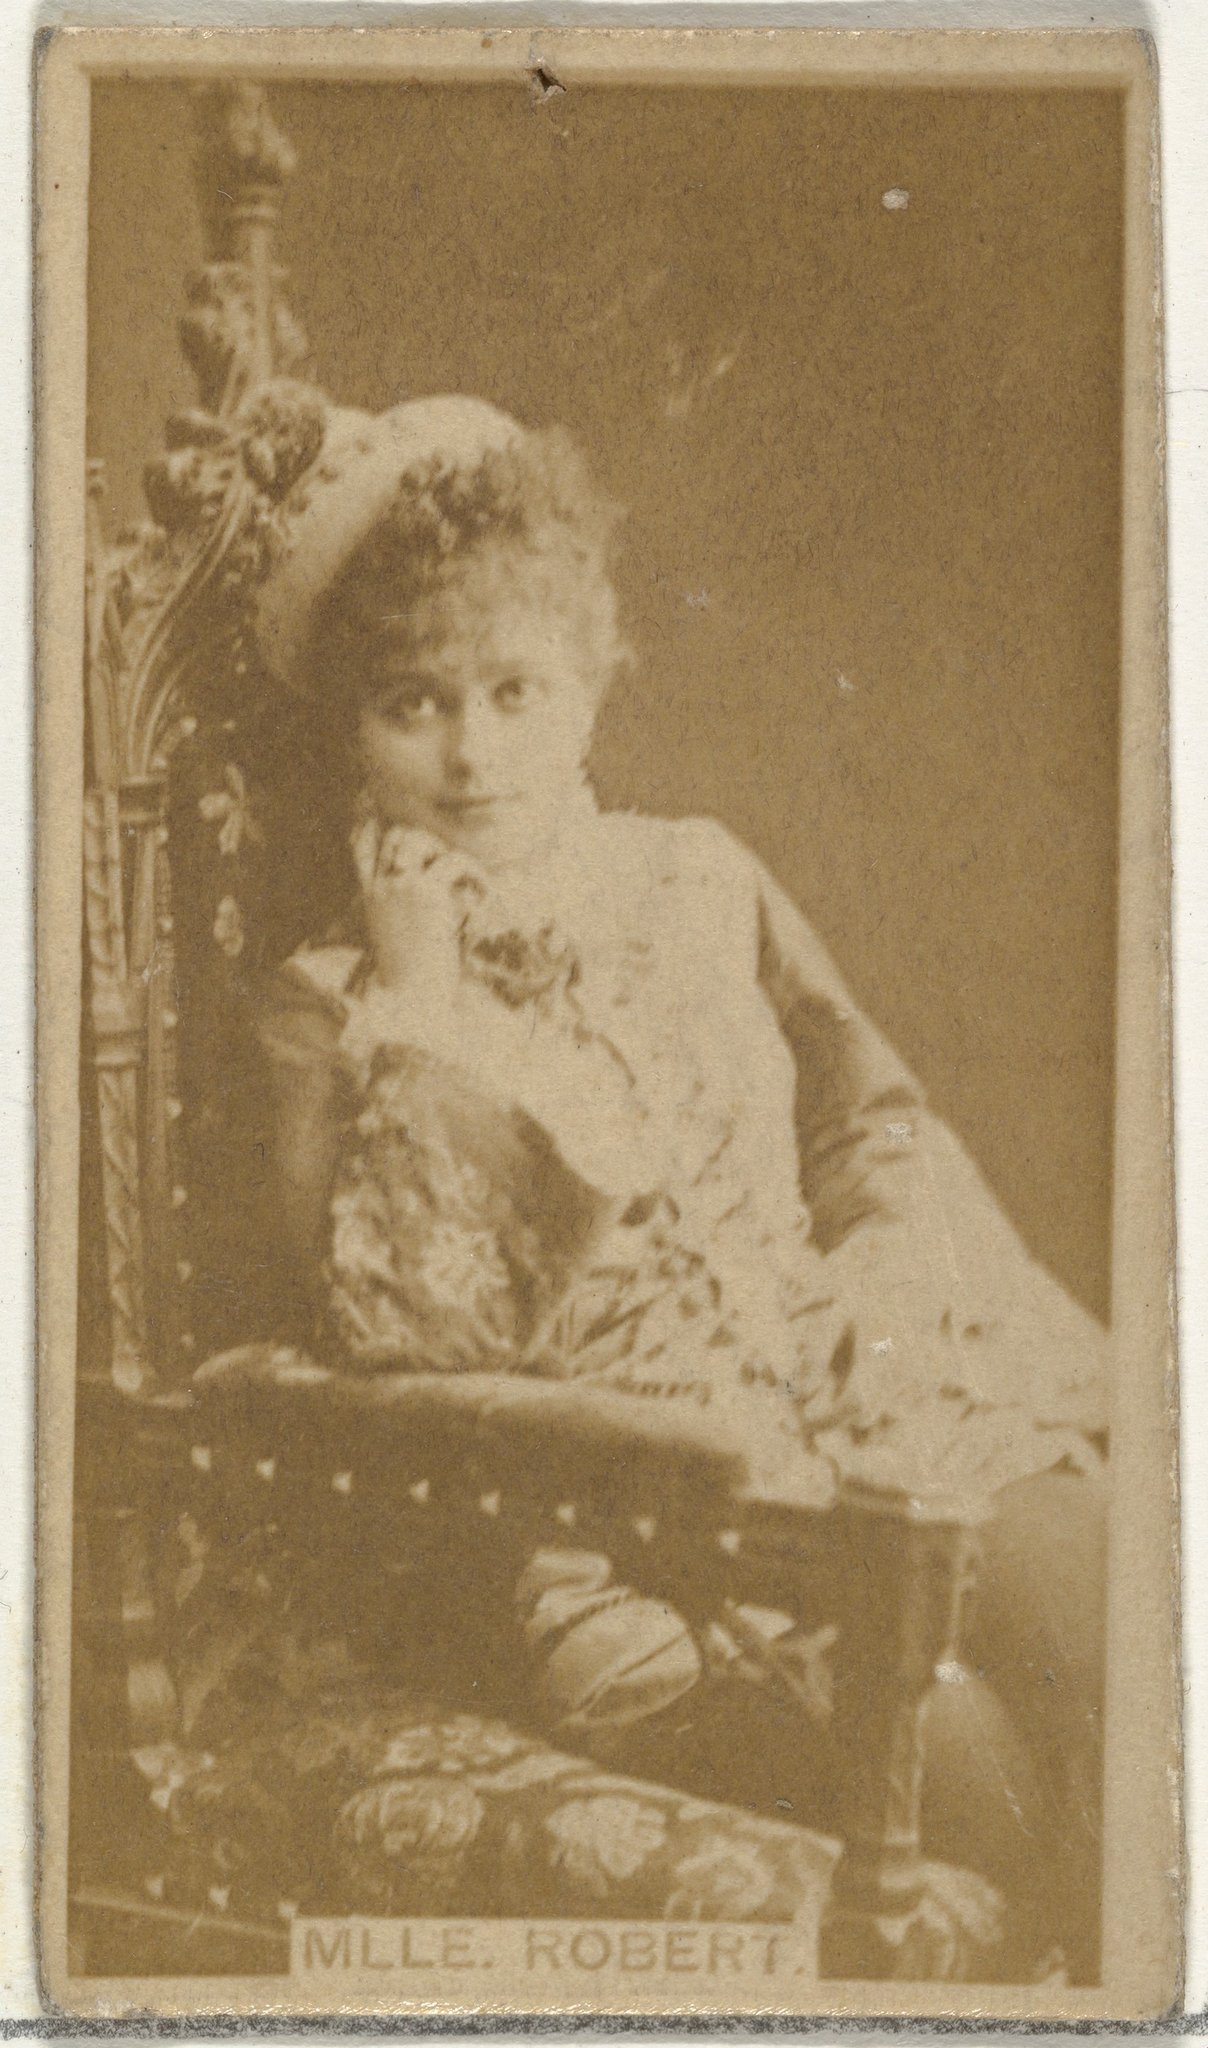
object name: photograph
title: Mlle. Robert, from the Actors and Actresses series (N145-8) issued by Duke Sons & Co. to promote Duke Cigarettes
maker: w. duke, sons & co.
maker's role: publisher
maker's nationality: american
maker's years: 1870-1920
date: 1891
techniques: albumen silver print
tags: portraits,women,actresses